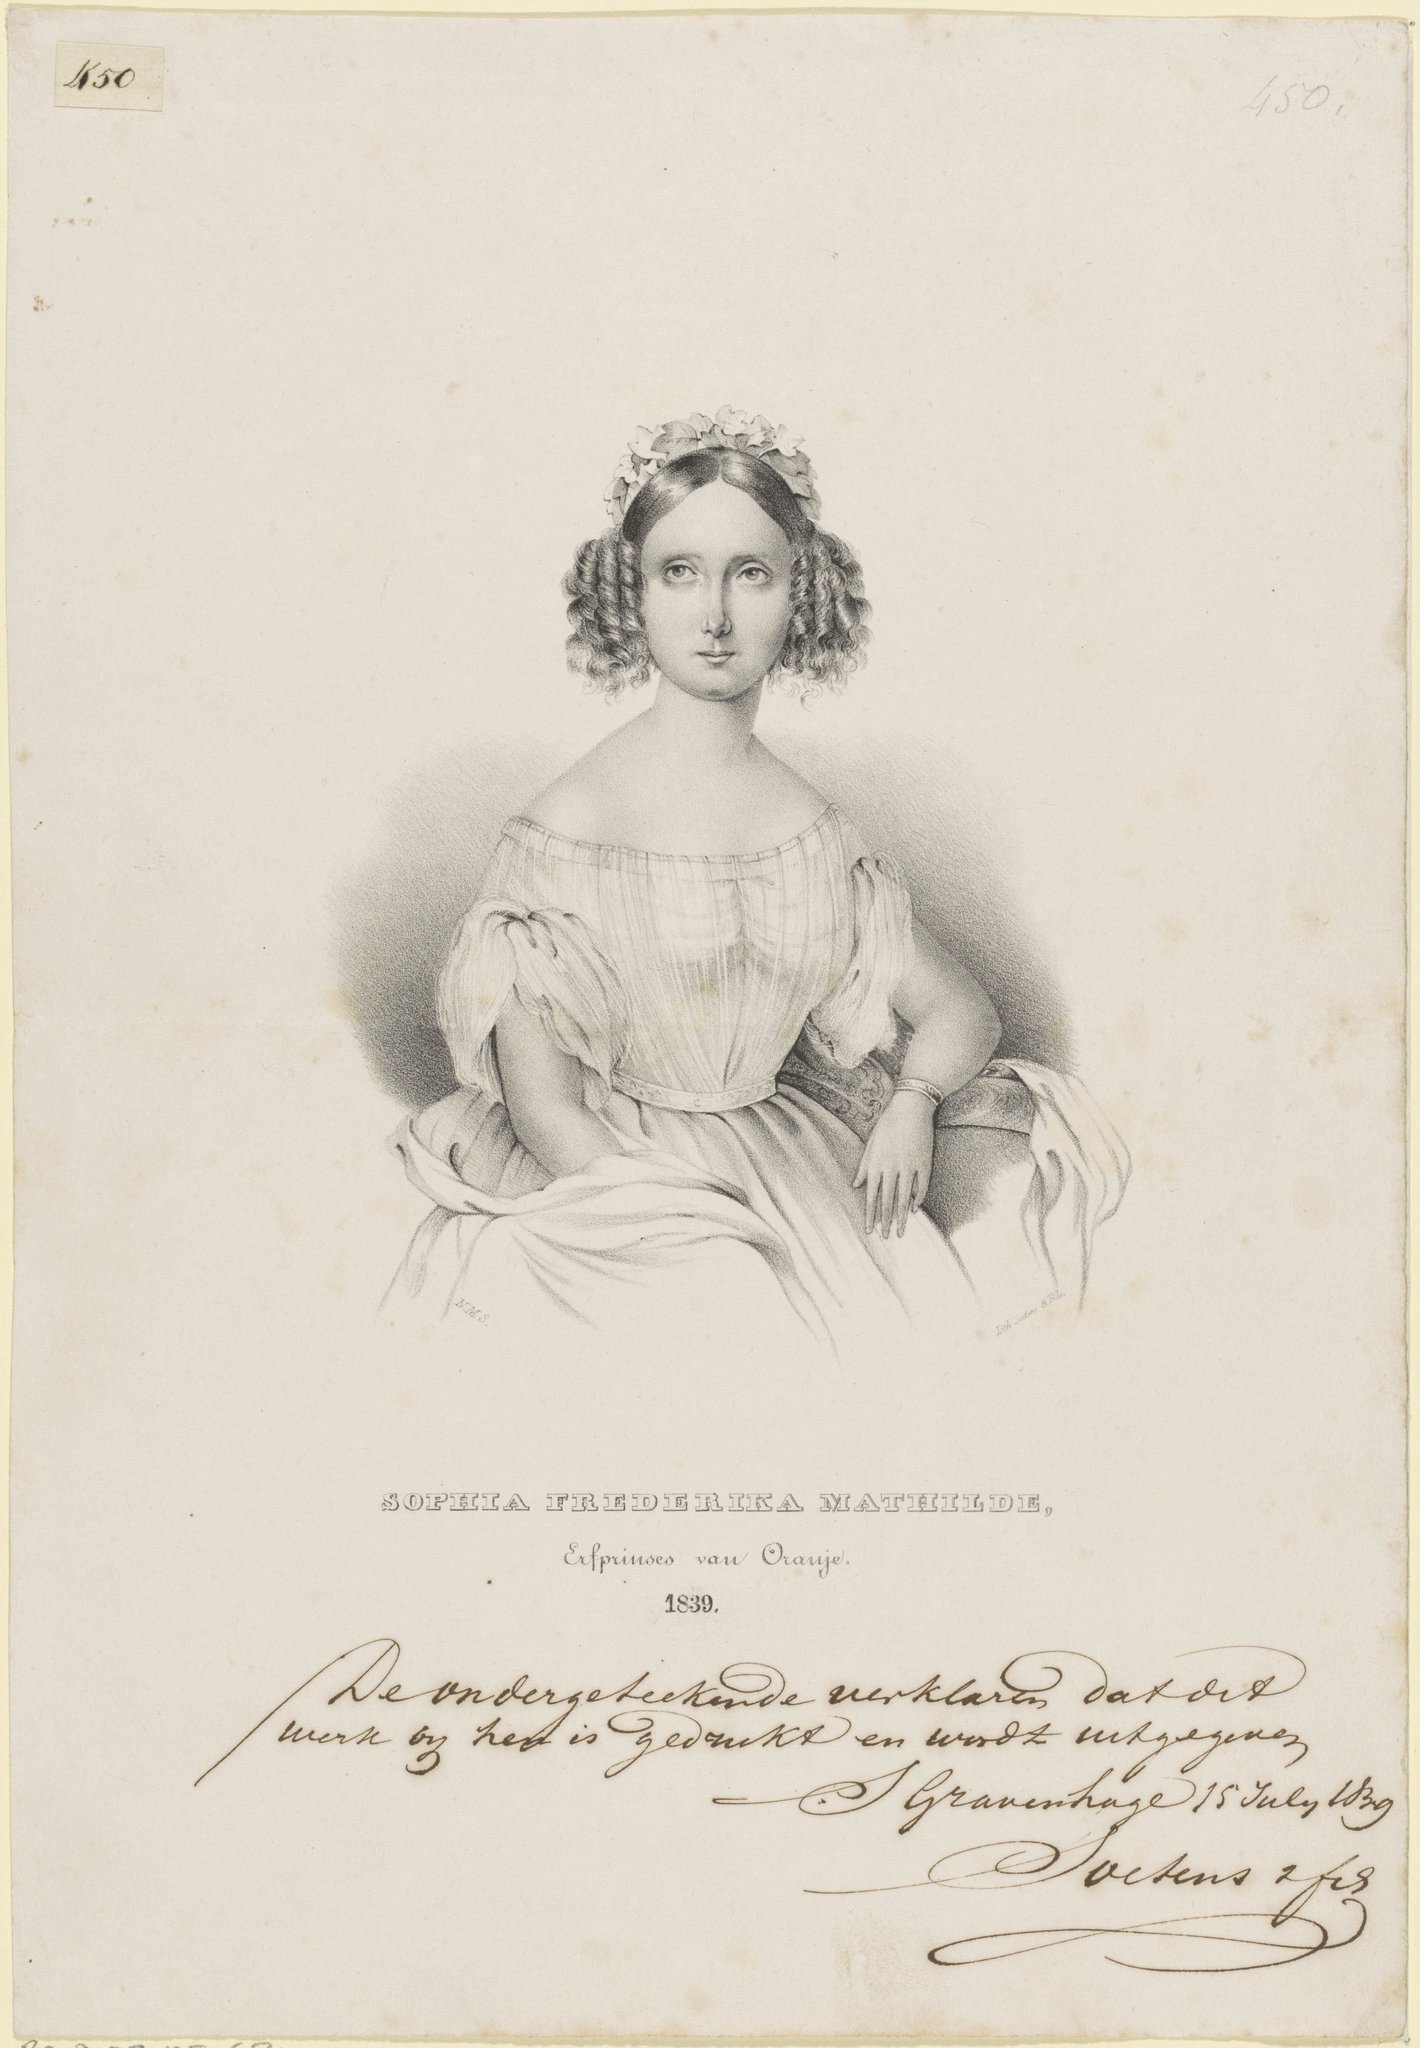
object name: print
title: Portret van Sophie van Württemberg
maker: nicolaas martinus schild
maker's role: draughtsman, print maker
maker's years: 1822-1840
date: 1837-1840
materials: paper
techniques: lithograph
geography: the hague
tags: the hague, sophia frederika mathilda van württemberg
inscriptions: : ‘De ondergeteekende verklaren dat dit werk bij hen is gedrukt en werdt uitgegeven S Gravenhage 15 July 1839 Soetens & fils’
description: Portret van Sophie. In de ondermarge haar naam en titel.